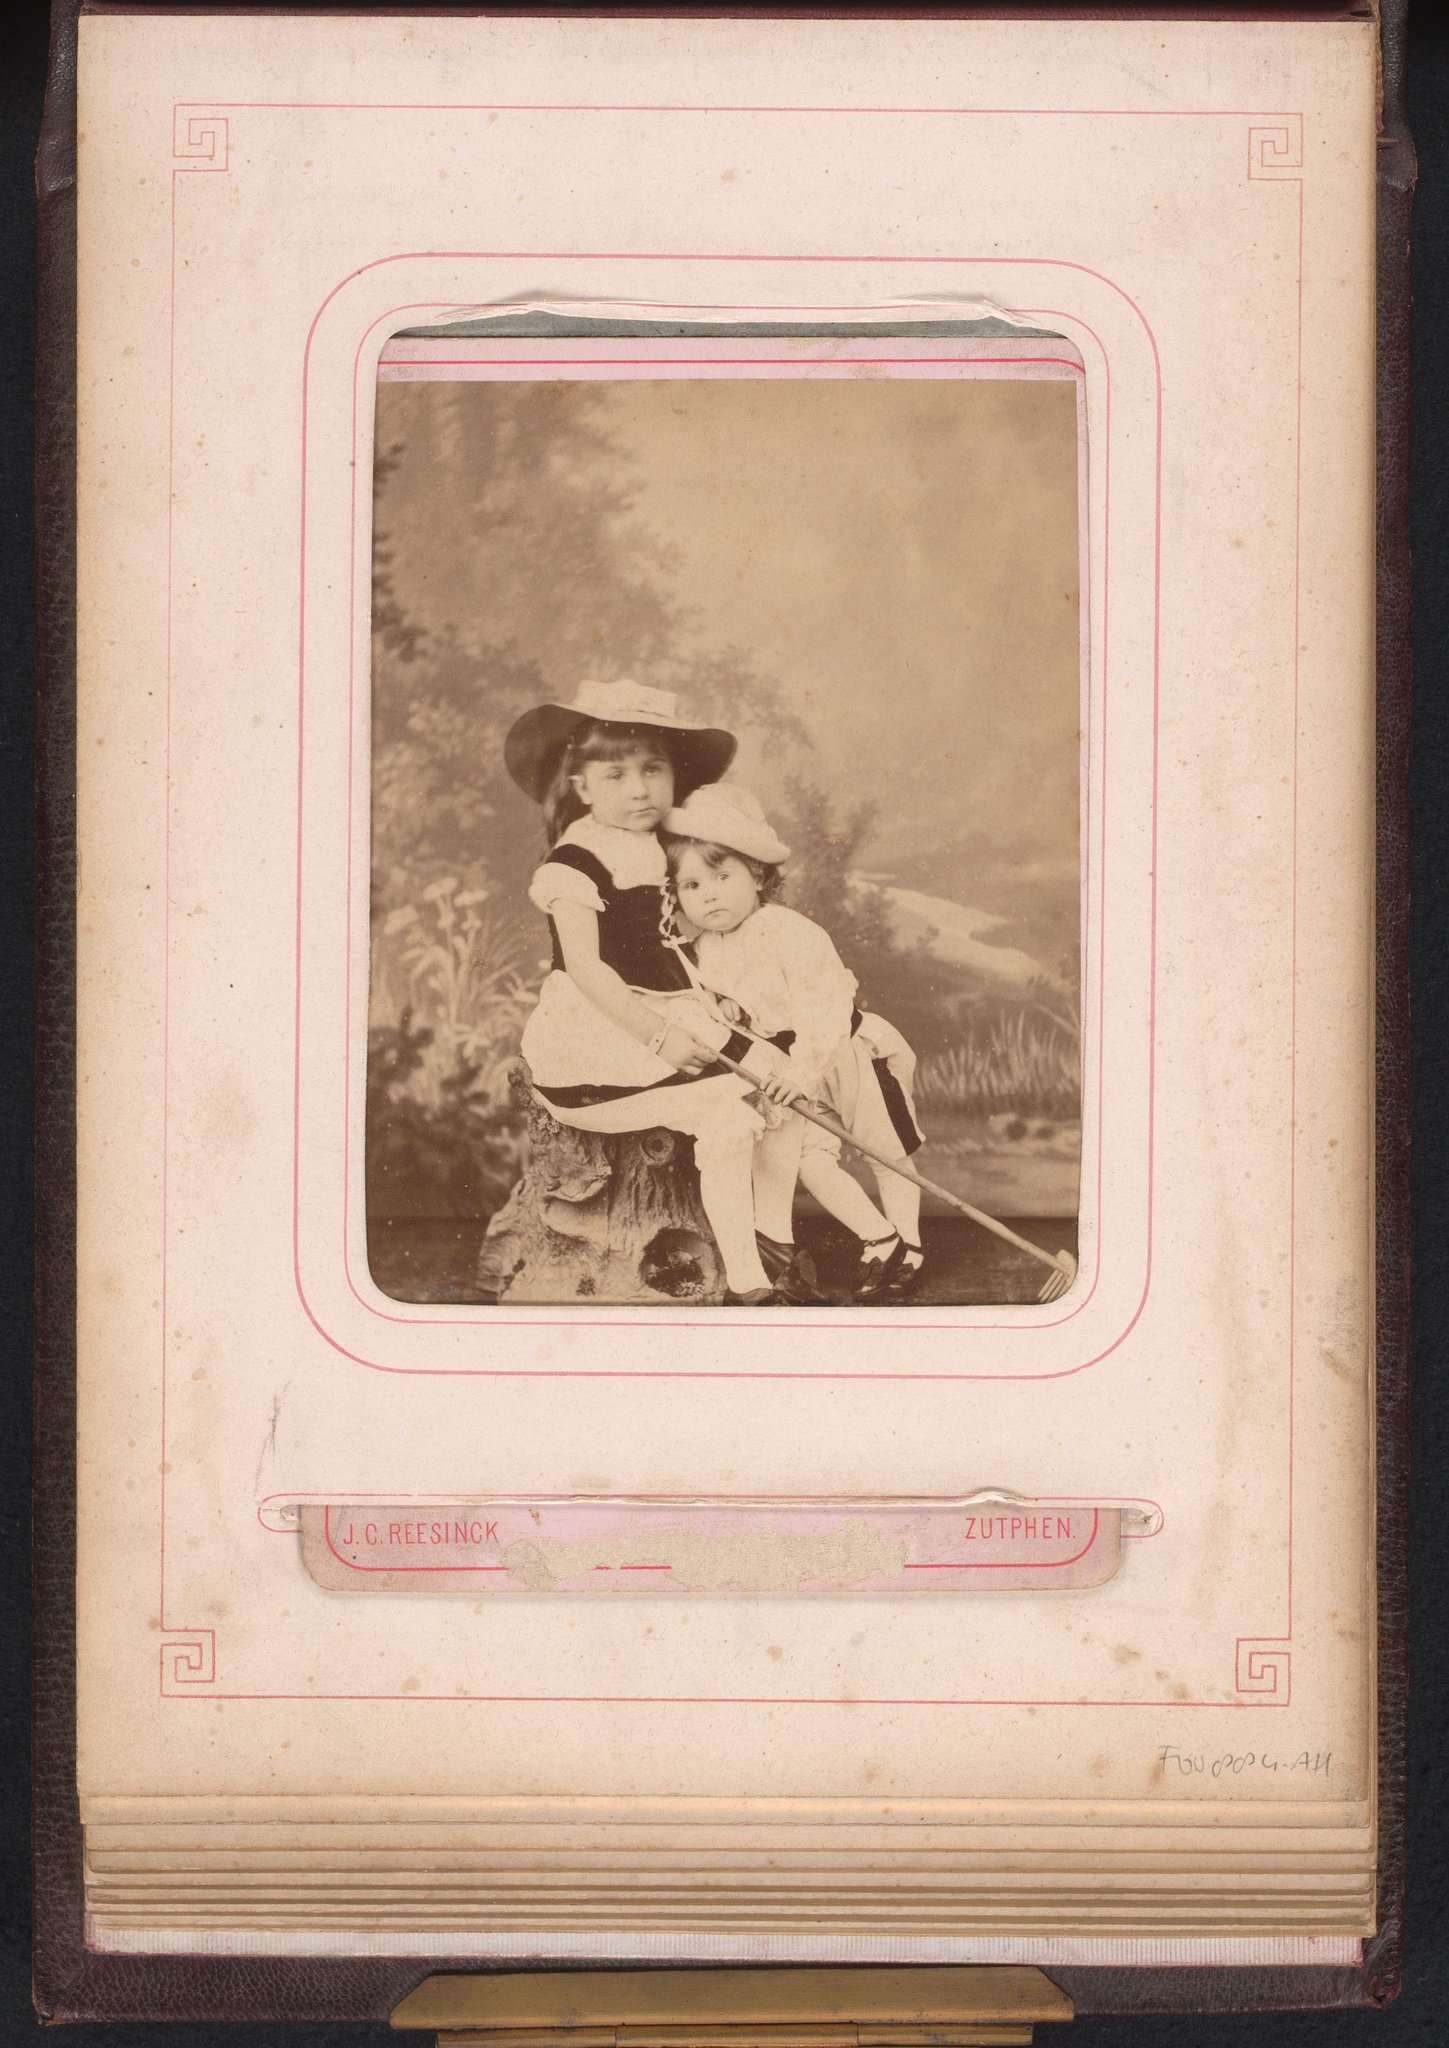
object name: album leaf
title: Twee meisjes met hoeden voor een landschapsdecor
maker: johan christiaan reesinck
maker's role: fotograaf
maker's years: 1838-1922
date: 1871-1897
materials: cardboard, paper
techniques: albumen print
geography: zutphen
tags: girl (child between toddler and youth), anonymous historical person portrayed, toddler (female)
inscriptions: inscription: ‘Salon/ [...] Zutphen/ Berkelkade./ Het cliché wordt voor verdere bestellingen bewaard.’, inscription: ‘Les soeurs inséparables.’, inscription: ‘J.C. Reesinck Zutphen.’